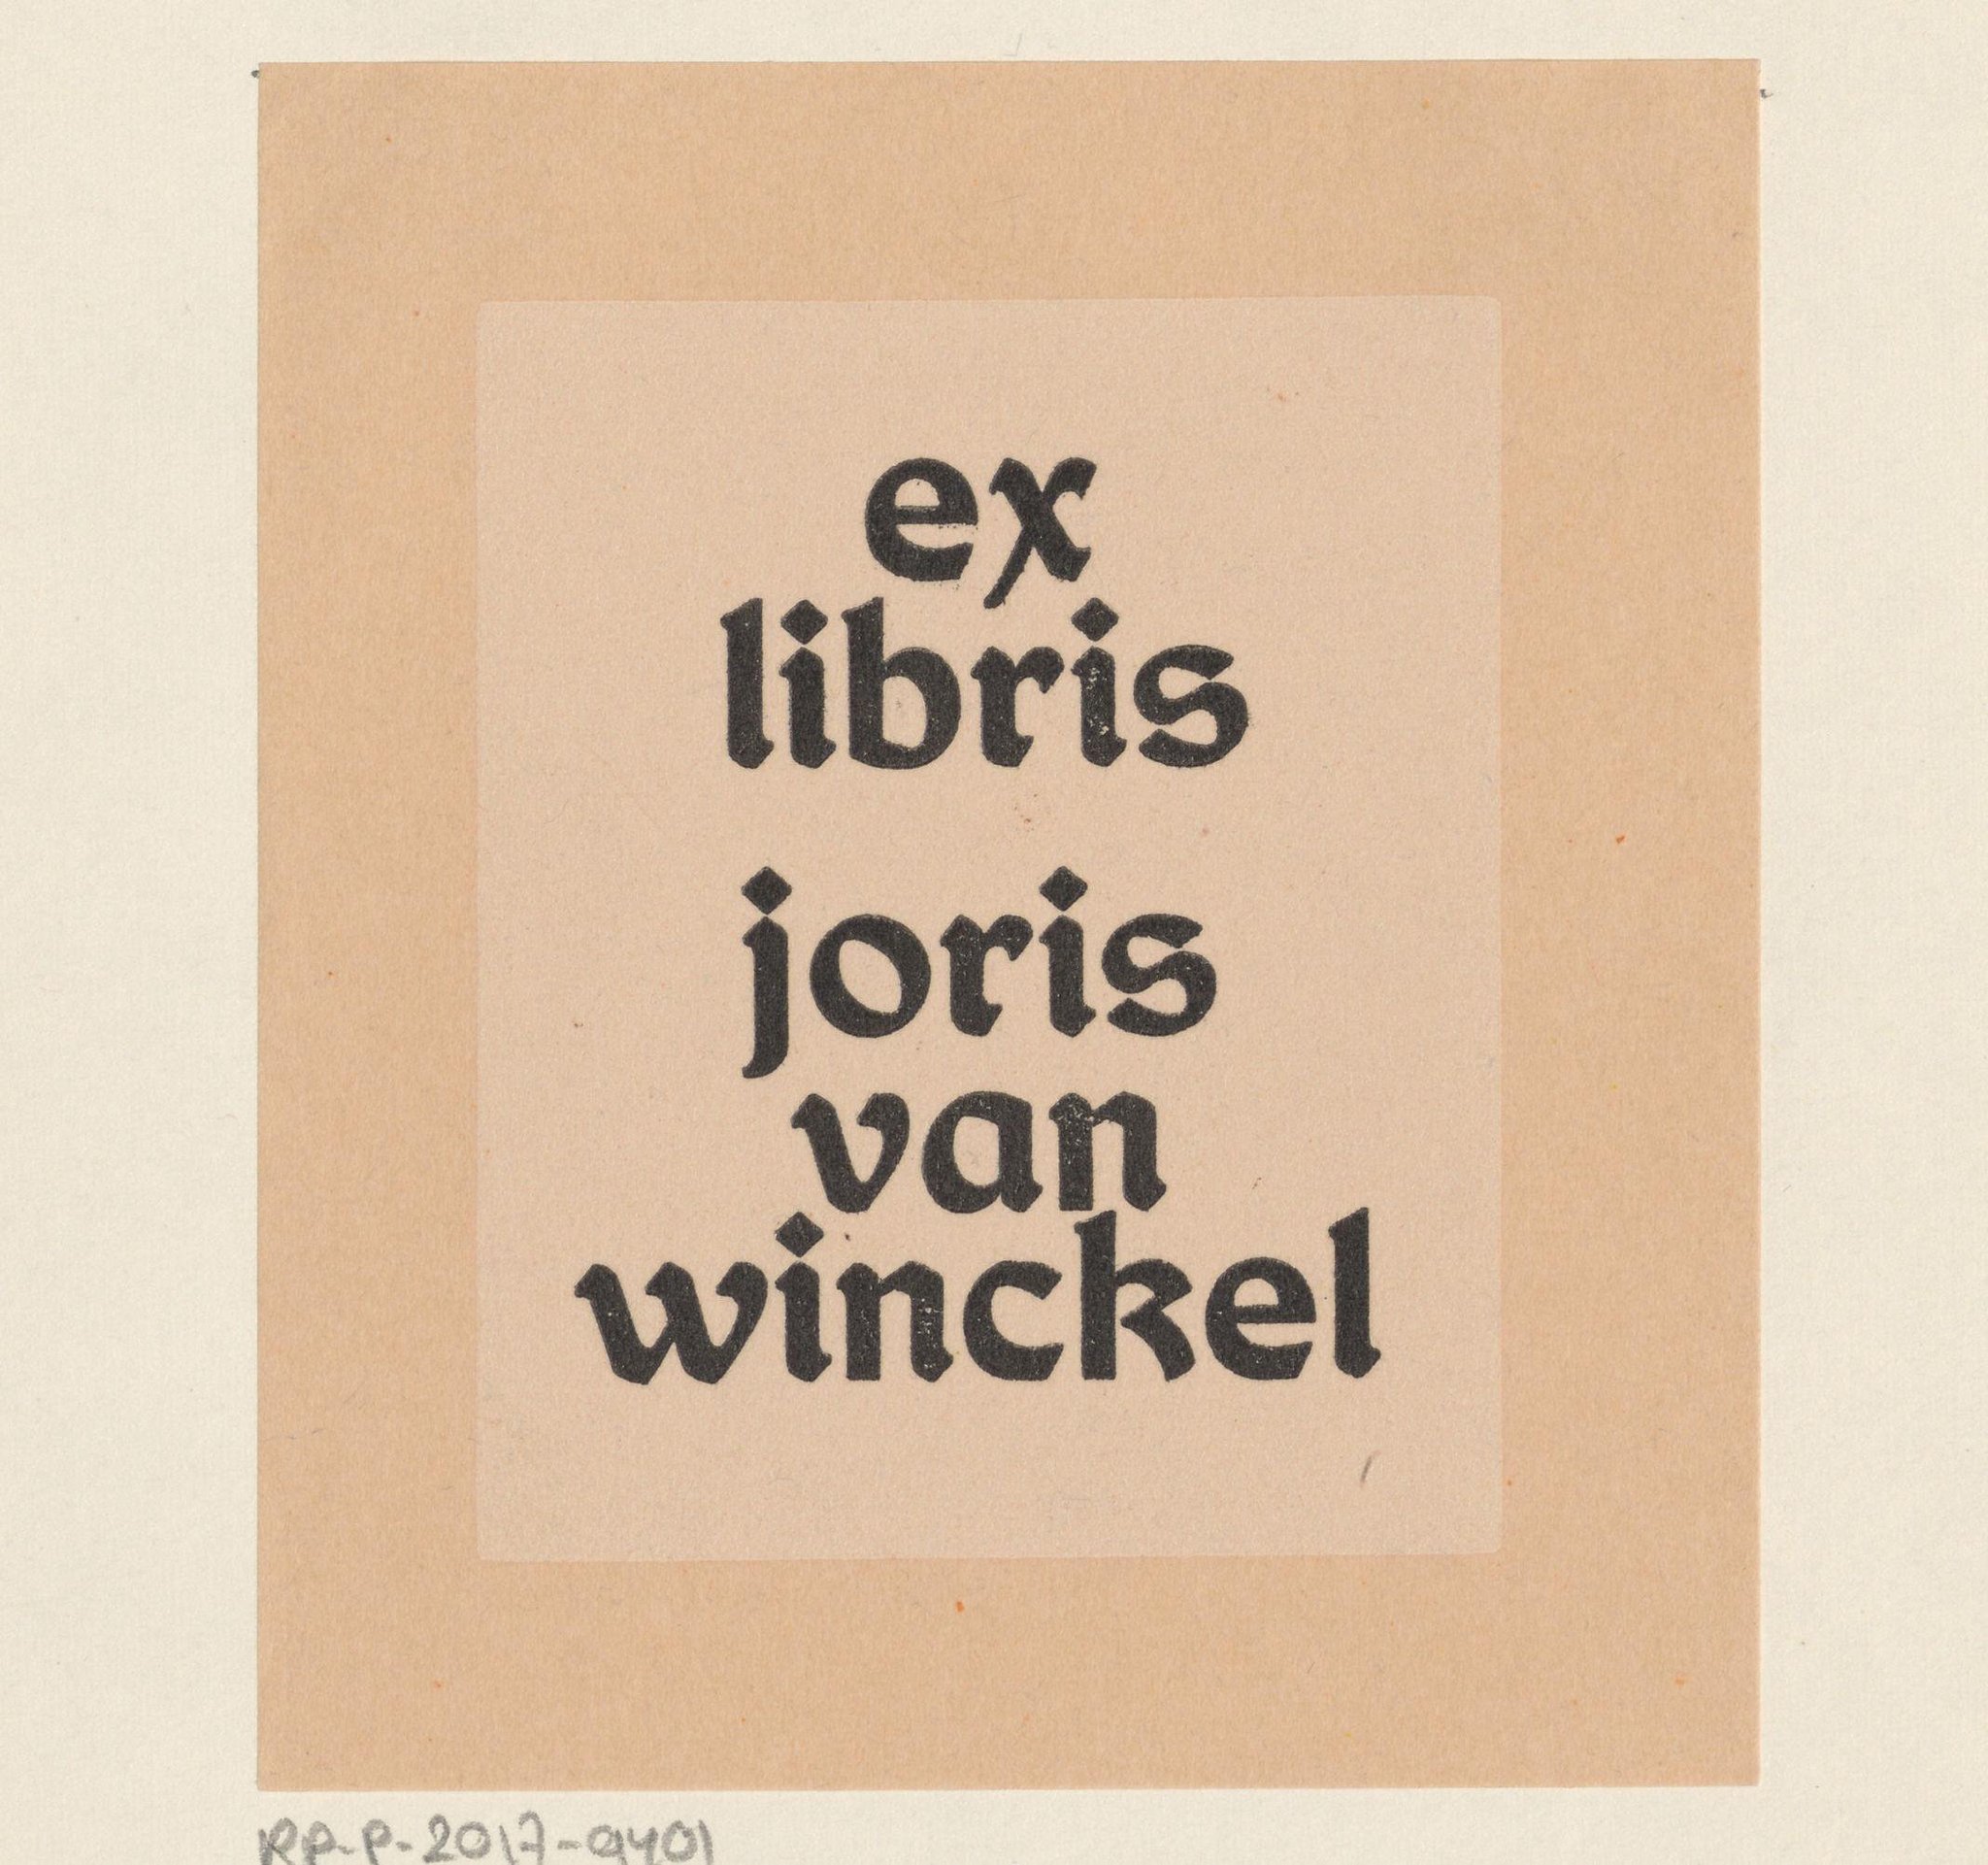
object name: bookplate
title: Ex libris van Joris Van Winckel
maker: Anonymous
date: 1949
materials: paper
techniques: printing block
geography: netherlands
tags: print maker, joris van winckel